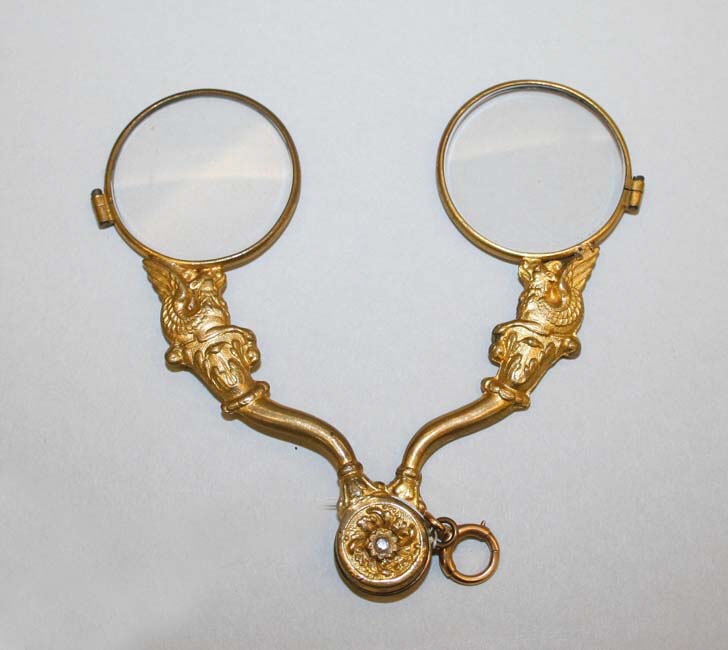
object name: lorgnette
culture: french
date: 1801-1833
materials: metal